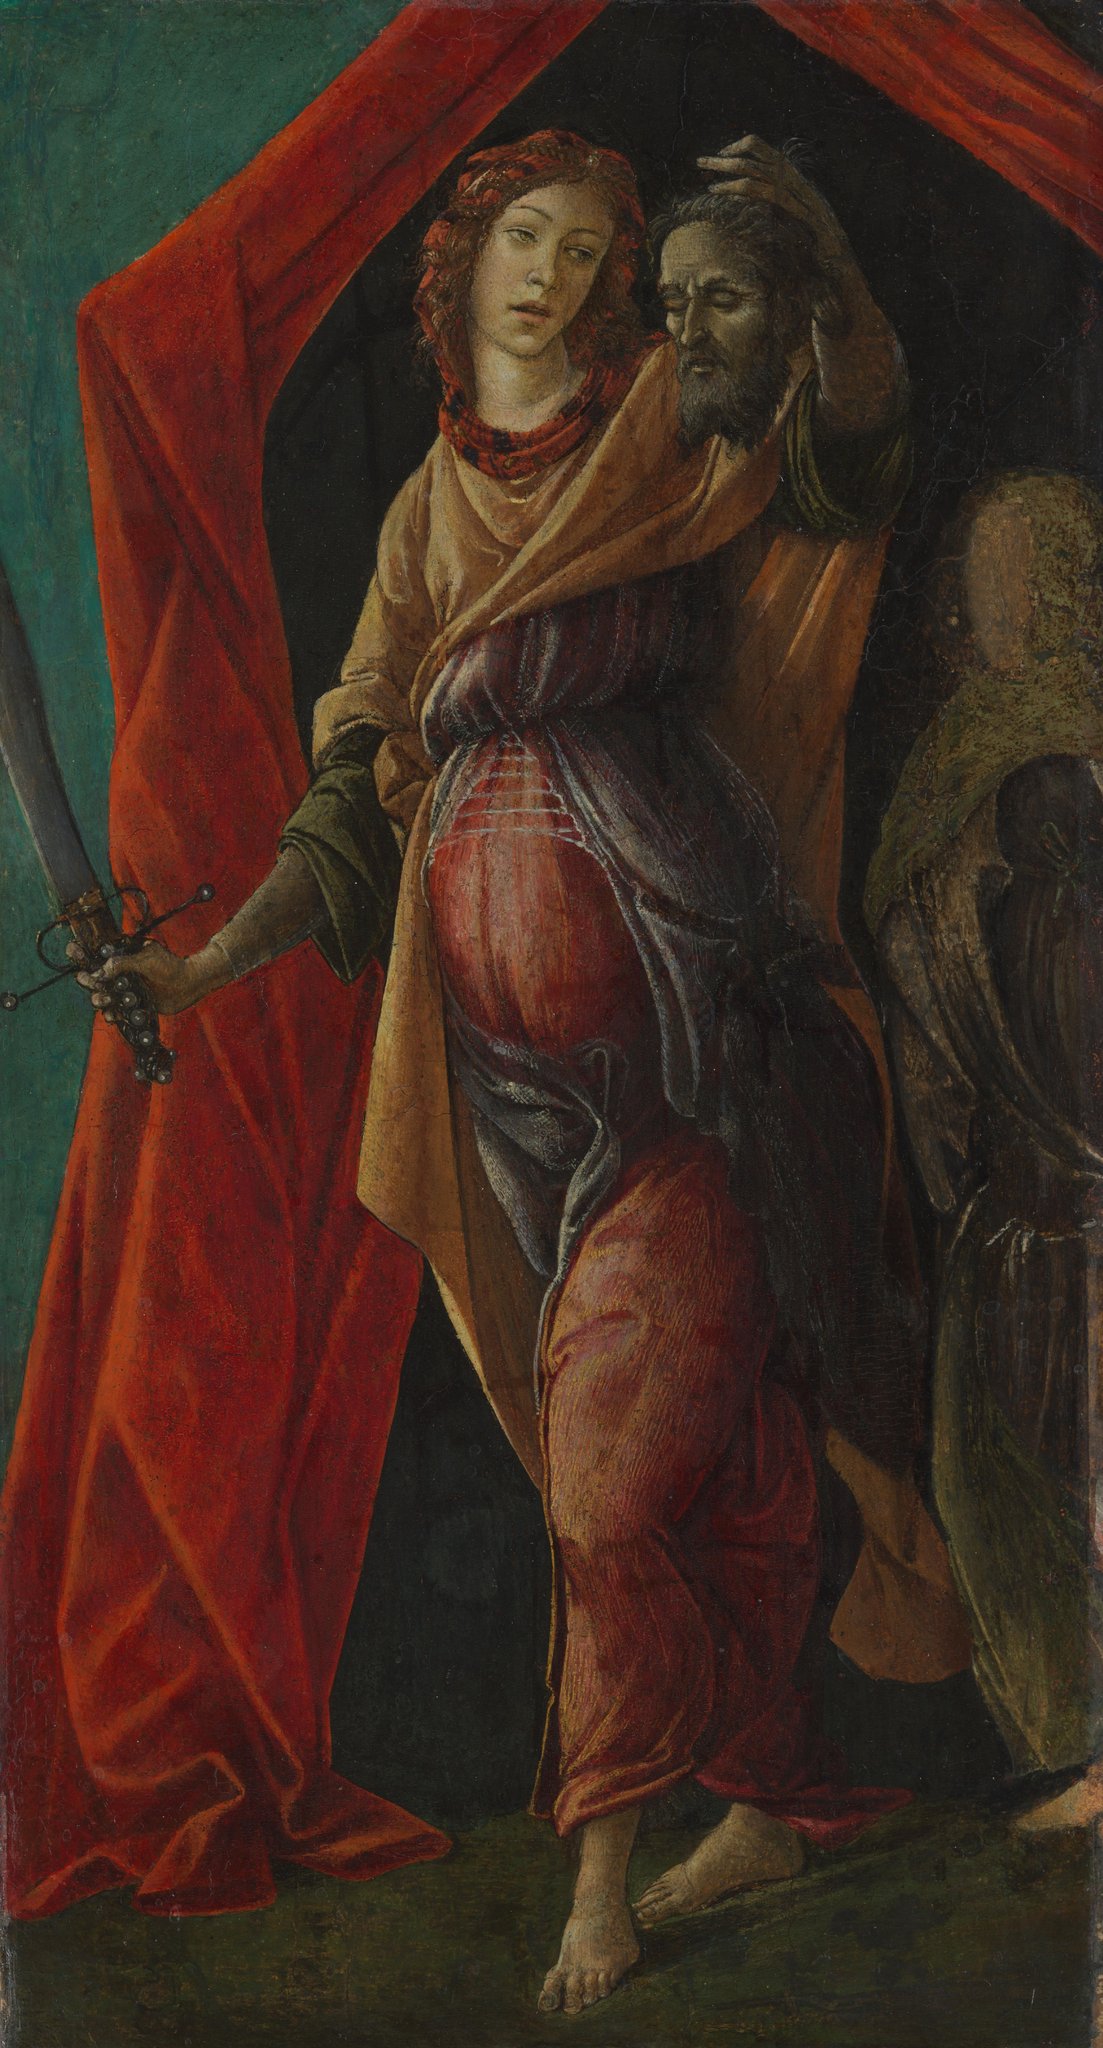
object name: painting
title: Judith with the Head of Holofernes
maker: sandro botticelli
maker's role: draughtsman, painter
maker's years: 1445-1510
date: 1497-1500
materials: oil, paint, panel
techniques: gilding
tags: judith shows holofernes' head to the people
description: Judith met het hoofd van Holofernes. Judith stapt uit de tentopening met het zwaard in de rechterhand en de afgehouwen kop in de linkerhand. Rechts een schim van de dienstmaagd.